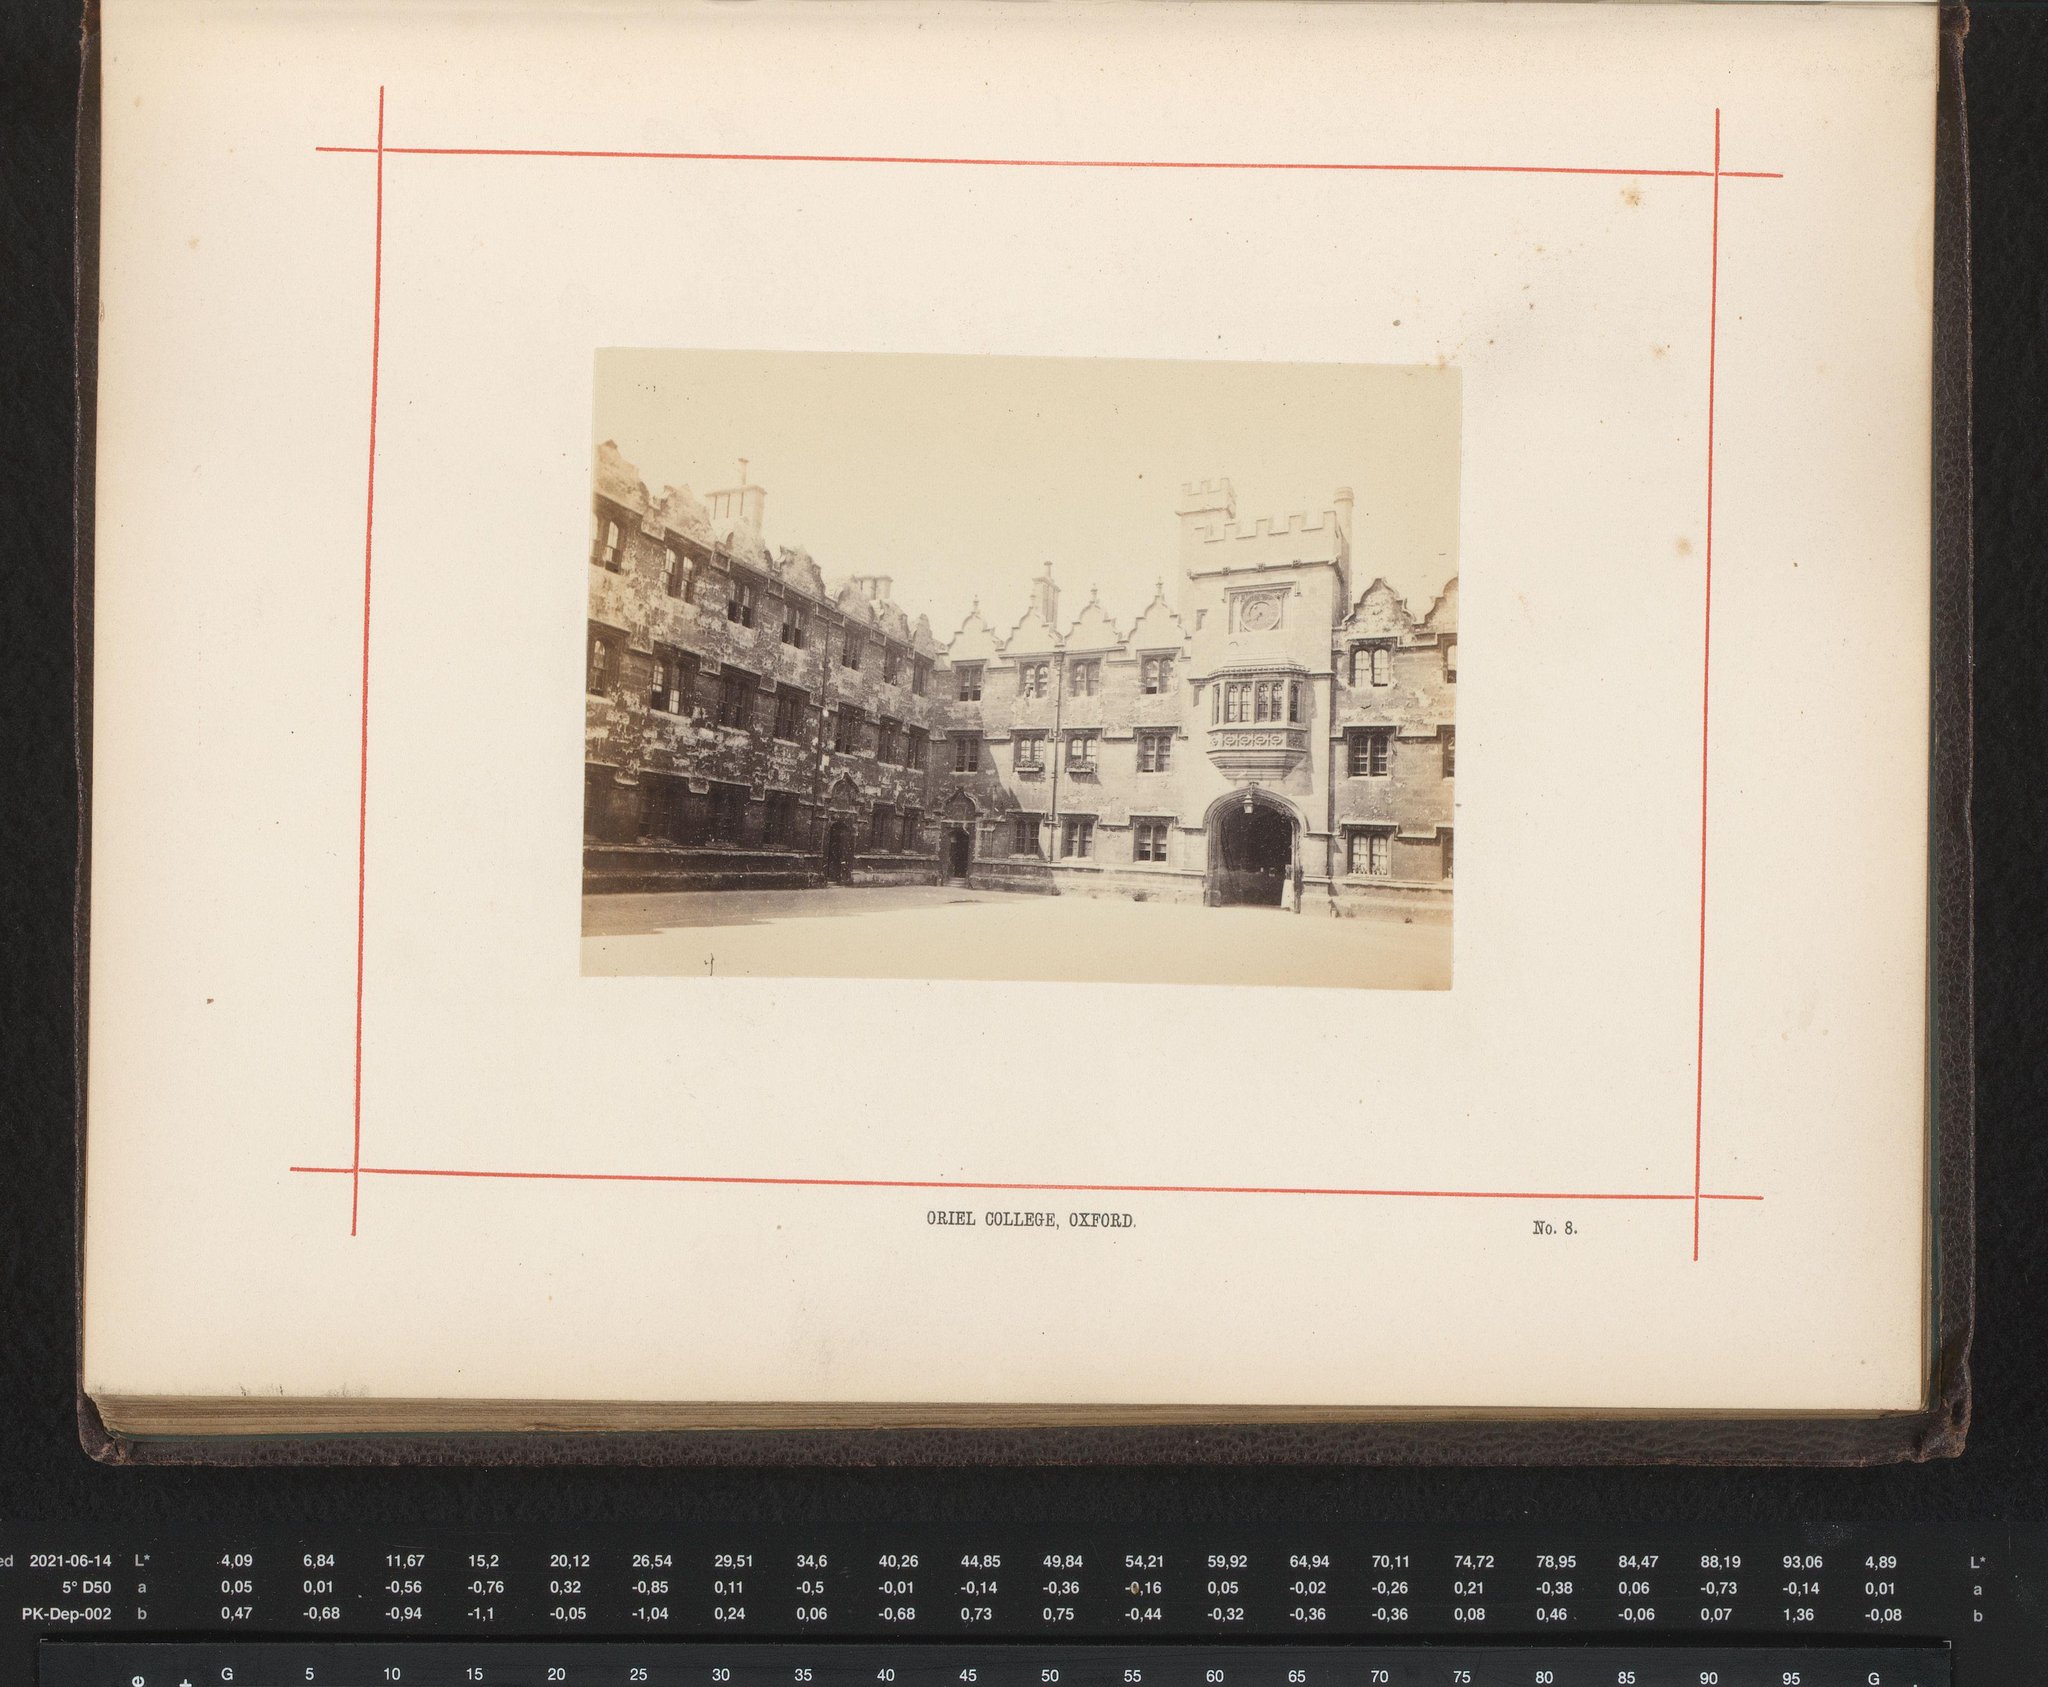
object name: photograph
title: Oriel College, Oxford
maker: william savage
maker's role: fotograaf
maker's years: 1817-1887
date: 1861-1866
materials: paper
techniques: albumen print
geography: oxford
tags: university building, college, courtyard